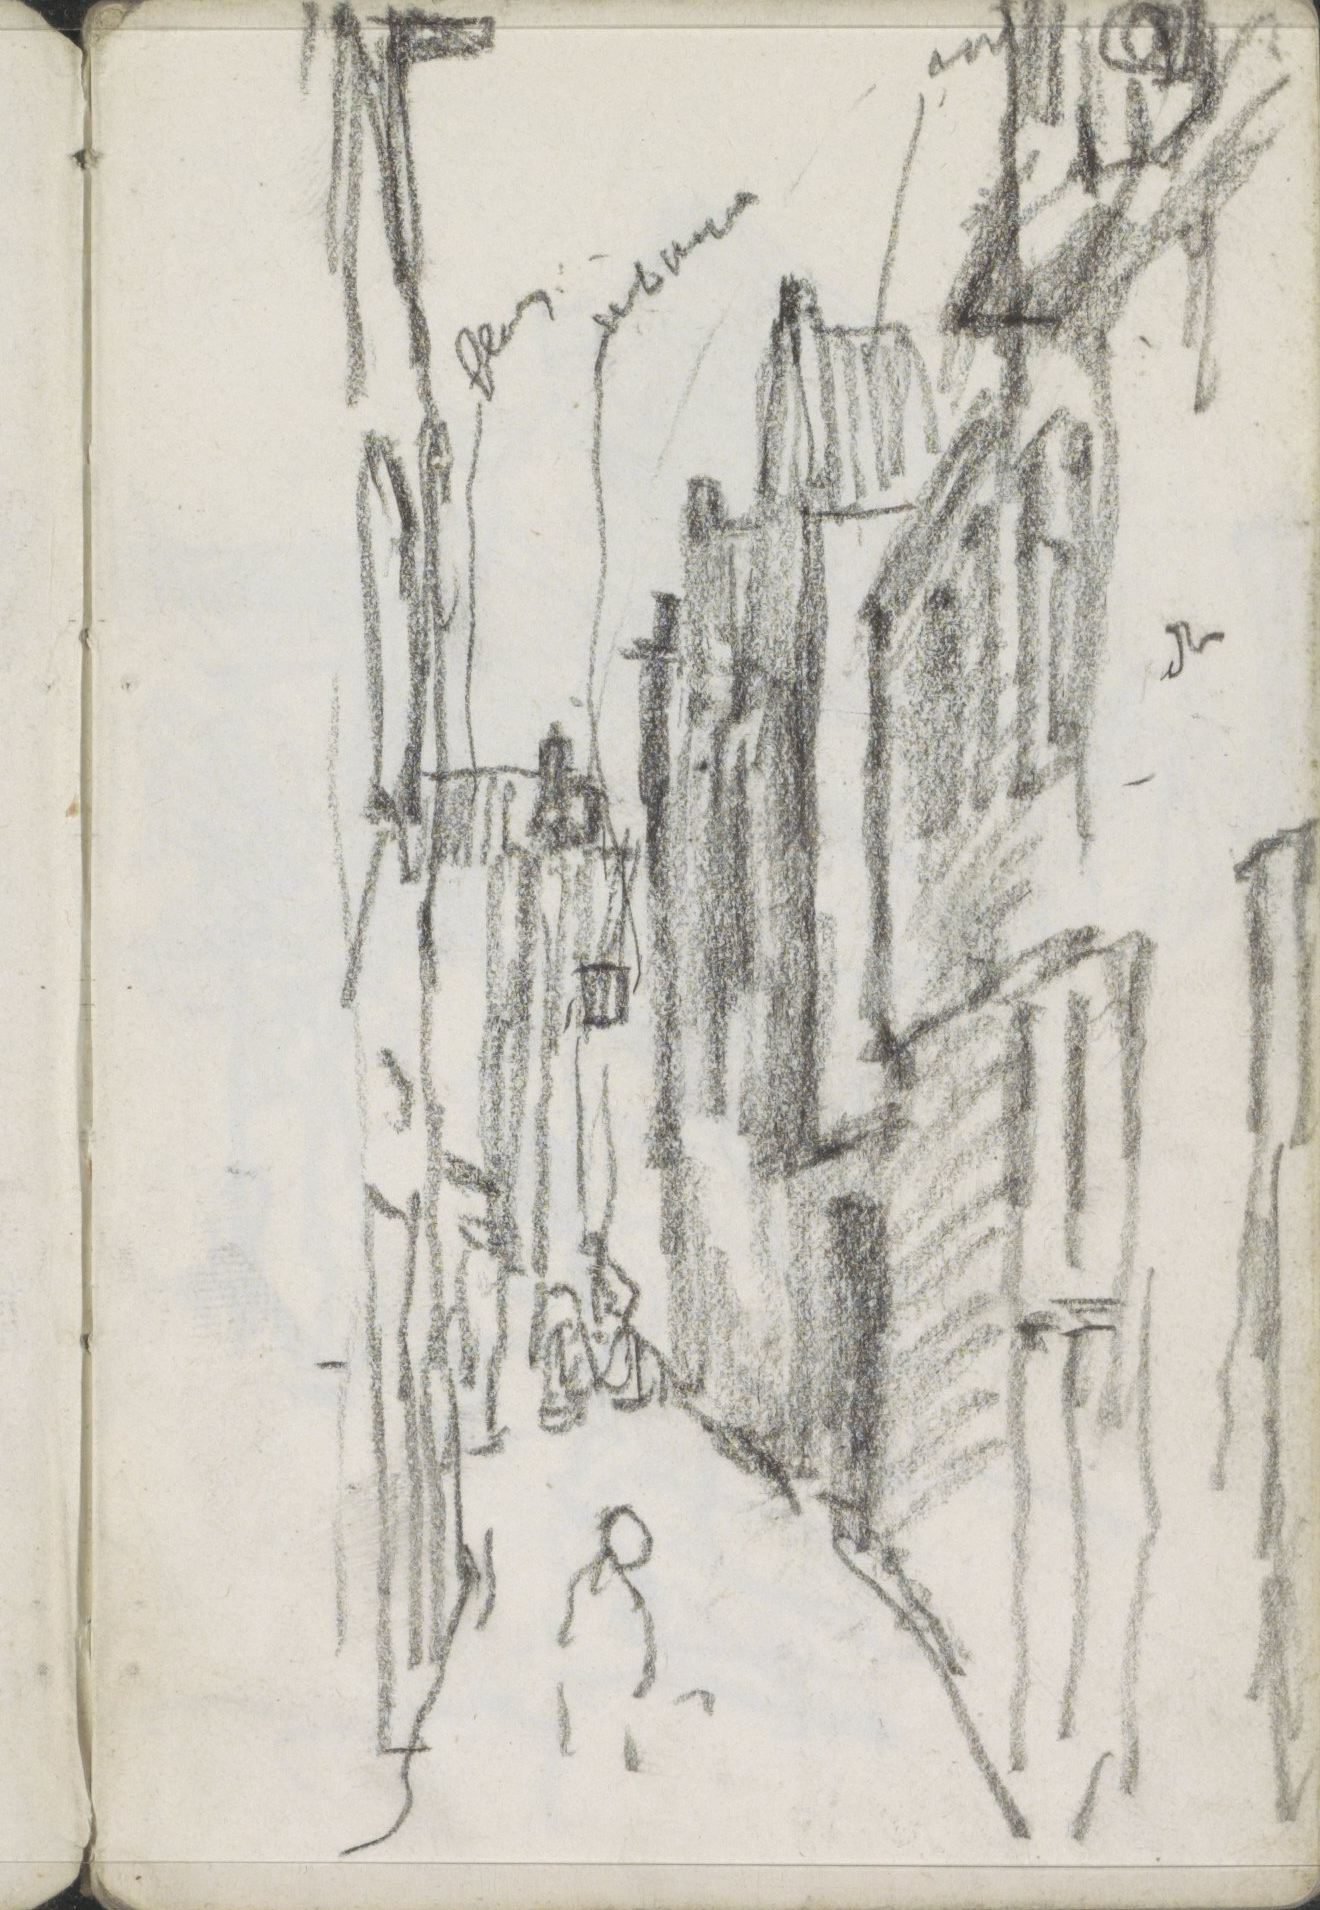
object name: sketchbook leaf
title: Figuren in een steeg, mogelijk de Baanbrugsteeg in Amsterdam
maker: george hendrik breitner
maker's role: draughtsman, painter, print maker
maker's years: 1857-1923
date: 1917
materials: chalk, paper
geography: amsterdam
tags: civic architecture; edifices; dwellings, lane, alley (+ city(-scape) with figures, staffage)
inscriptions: kleurnotitie, handgeschreven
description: Pagina 4 uit een schetsboek met 44 bladen.